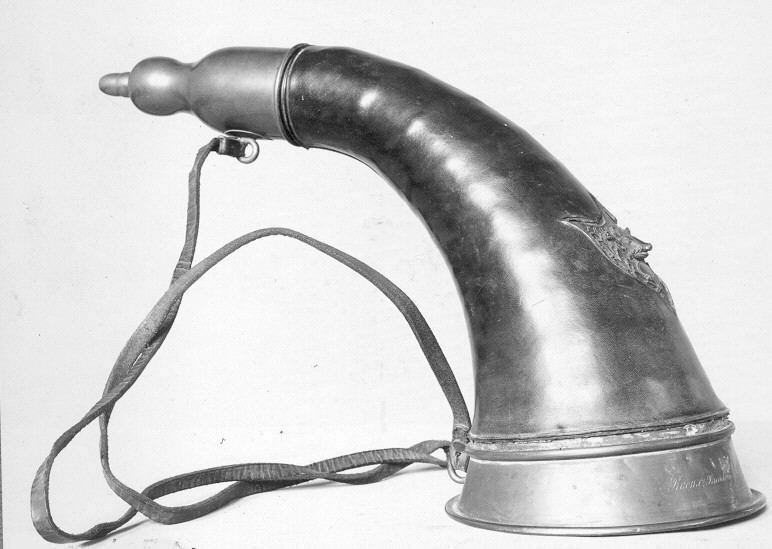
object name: hunting horn in d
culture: french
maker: raoux family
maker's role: maker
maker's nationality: french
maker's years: 1680-1900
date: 1866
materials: brass, lead, leather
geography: france